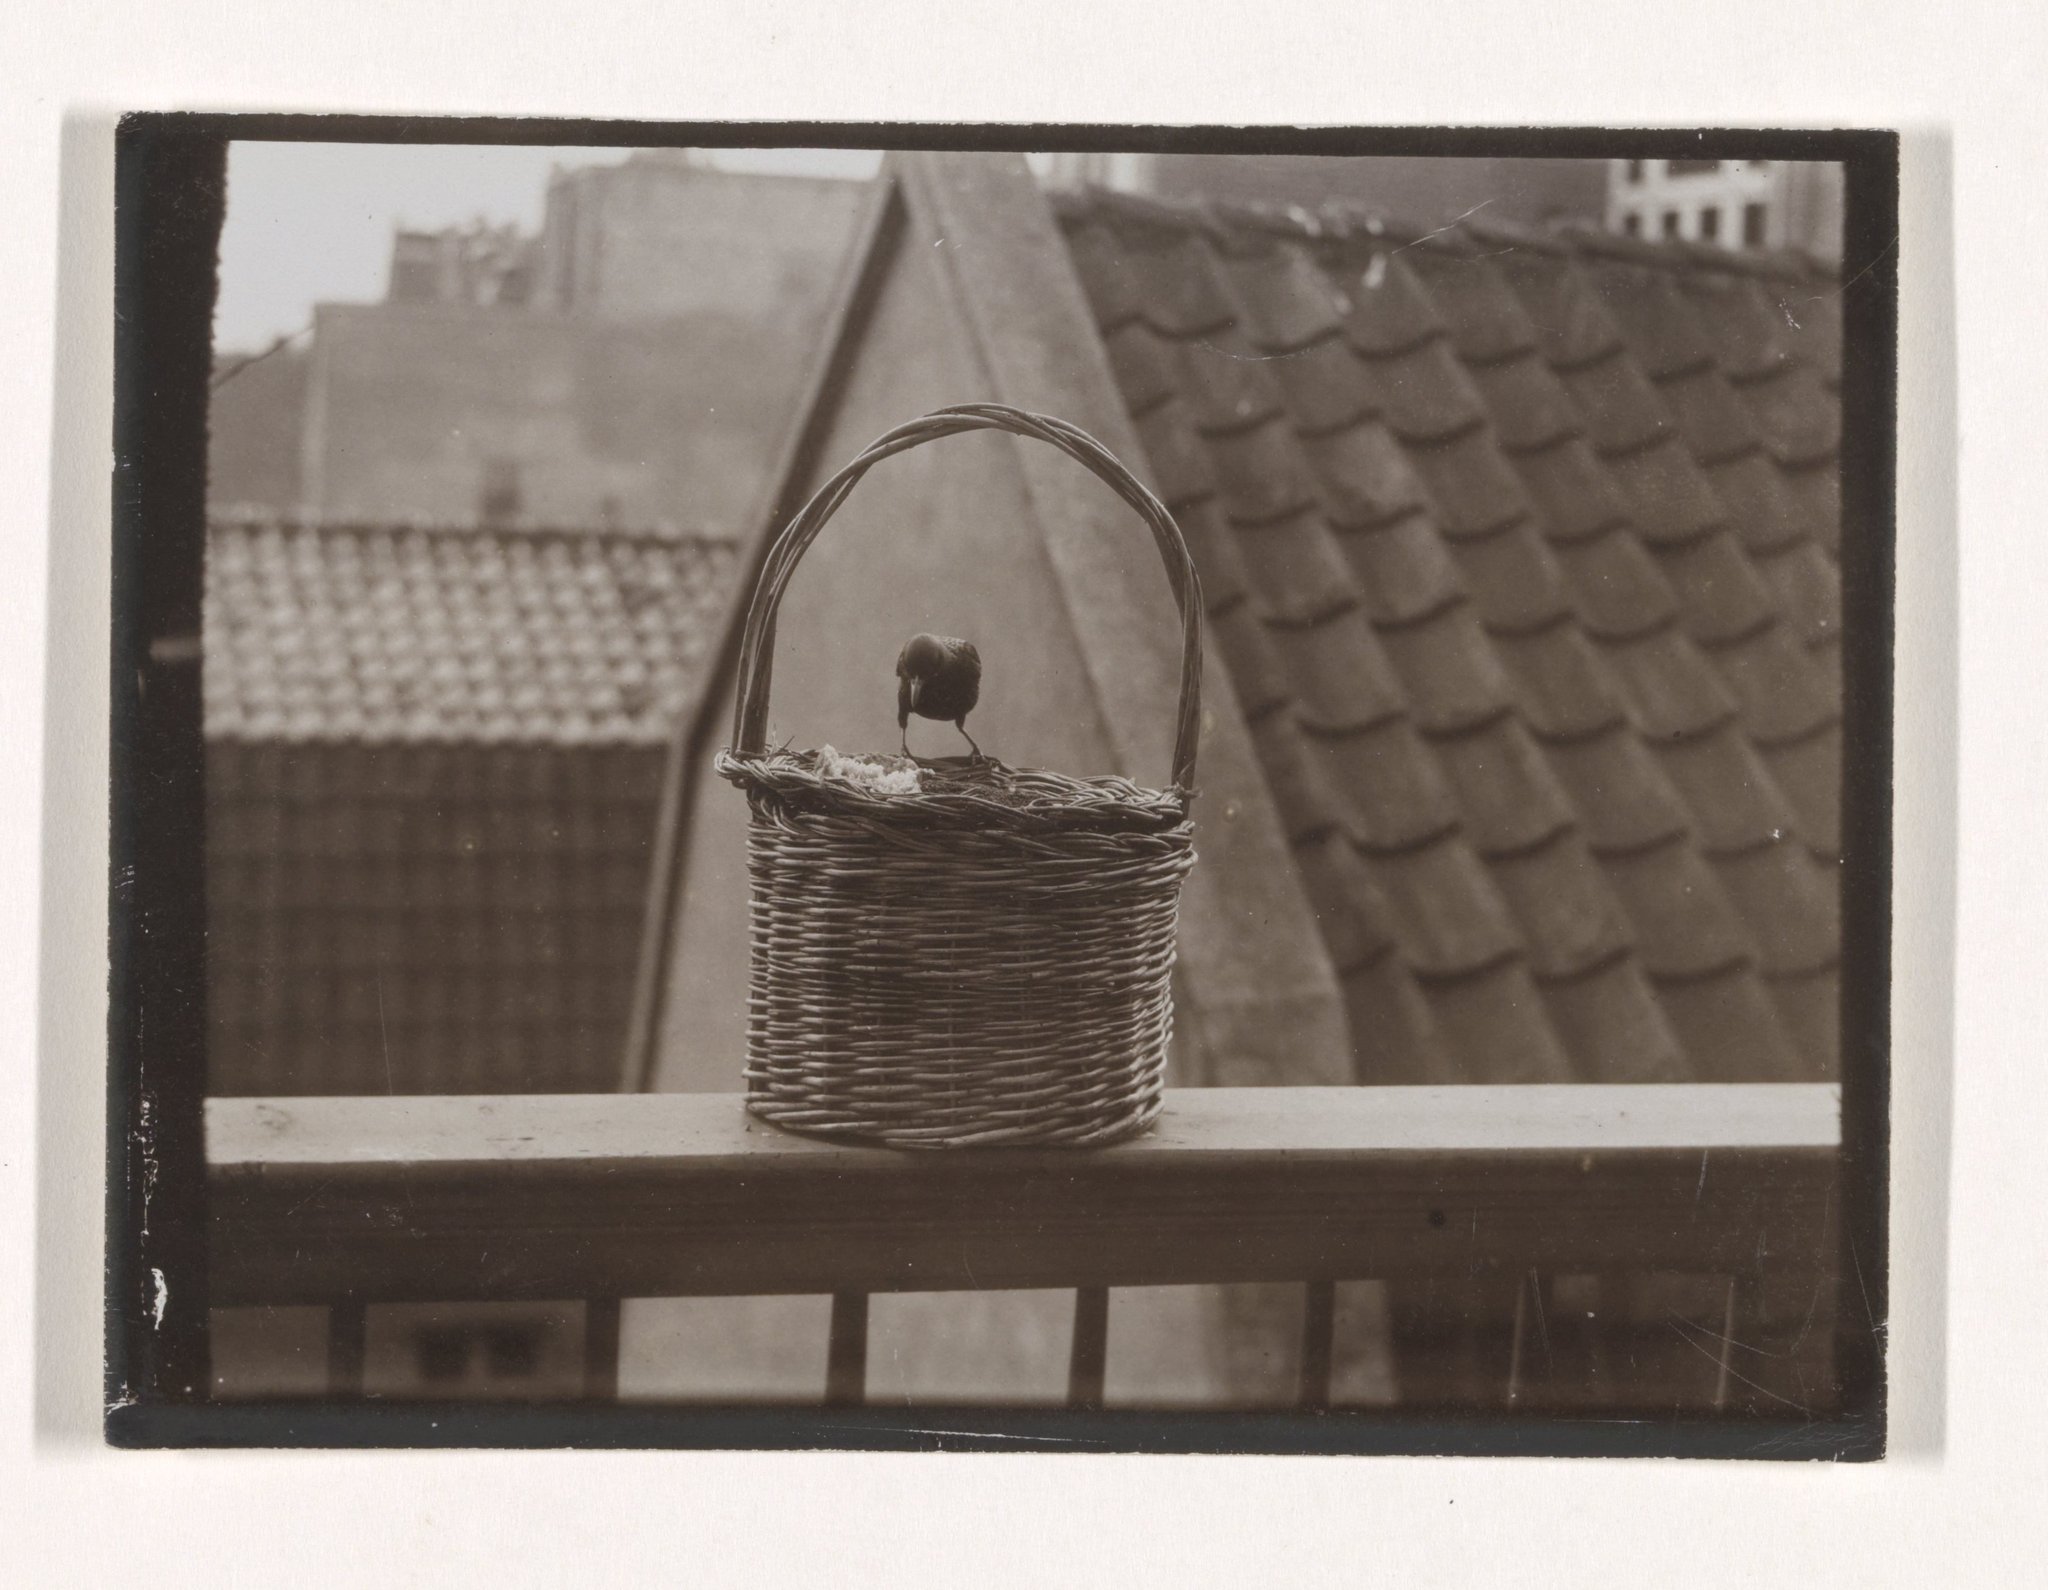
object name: photograph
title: Sparrows on a Balcony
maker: richard tepe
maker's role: fotograaf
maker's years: 1864-1952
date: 1900-1930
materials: cardboard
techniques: collodion silver print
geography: netherlands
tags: song-birds: sparrow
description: People first began to realize around 1900 that nature had to be protected. Amateur photographer Tepe used photography to this end and was one of the champions of the nature conservation movement. Tepe specialized in bird photography and was the founder of this genre in the Netherlands. Sometimes a basket was used to lure the birds, and at other times they ate from someone’s hand.